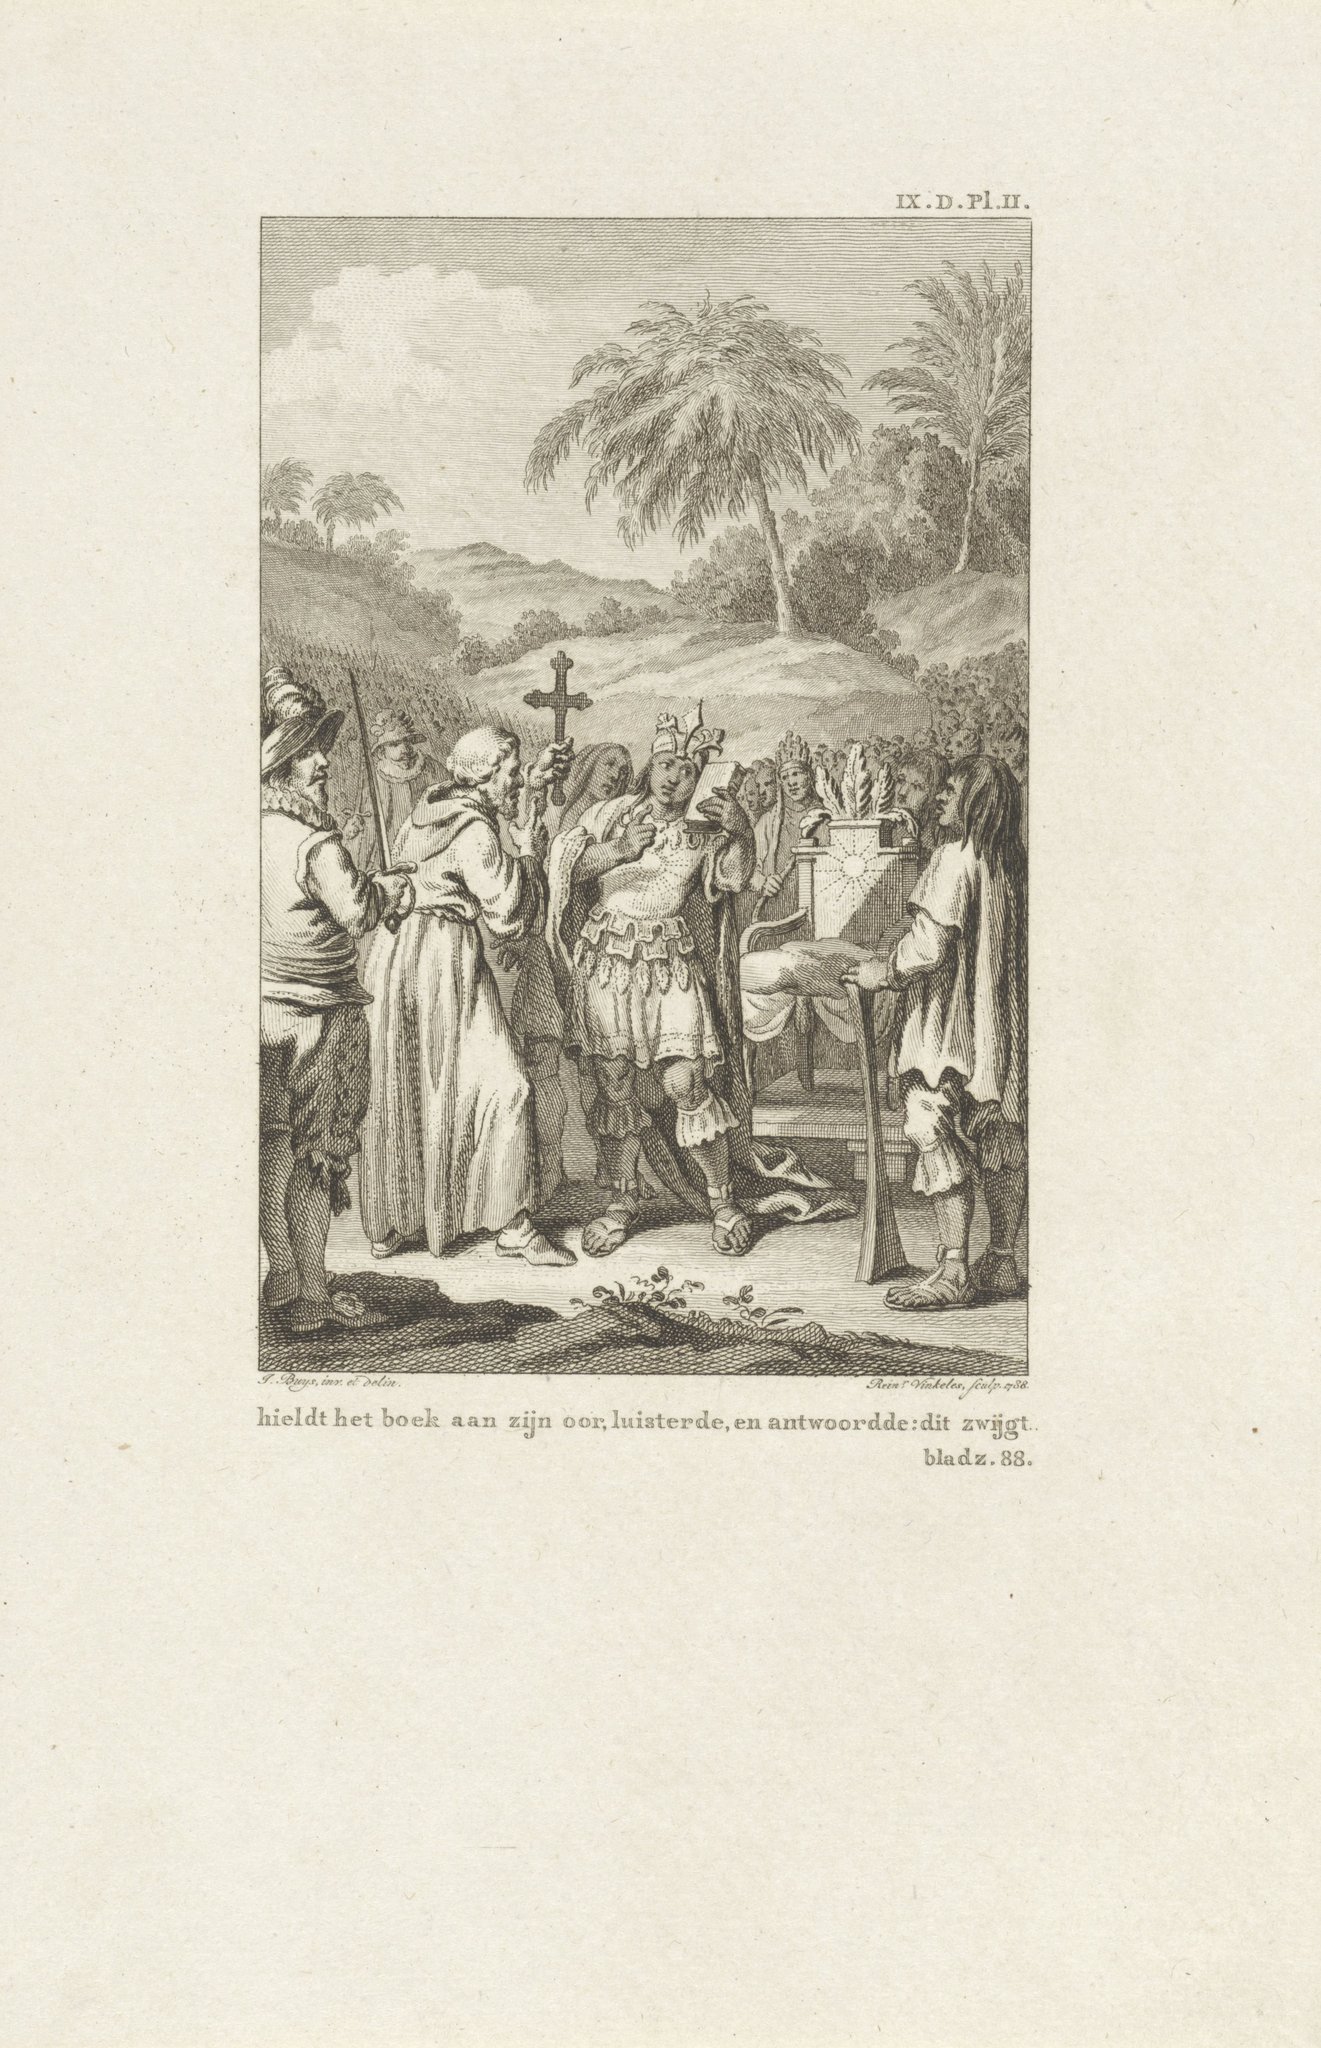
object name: print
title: Incaleider Atahualpa wordt bekeerd tot het katholieke geloof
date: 1788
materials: paper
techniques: engraving, etching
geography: amsterdam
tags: ancient american script (maya, aztec, inca), europeans: spaniards, indigenous peoples of south america, crucifix ~ personal devotion, extinct, 'historical' peoples (with name), the bible as a book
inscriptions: collector's mark: Lugt 240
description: Spanjaarden proberen de Incaheerser Atahualpa te bekeren tot het katholieke geloof. Hij heeft zijn oor tegen de bijbel. Voor hem houdt een geestelijke een crucifix vast. Rechtsboven: IX.D.Pl.II. Rechtsonder: Bladz.88.